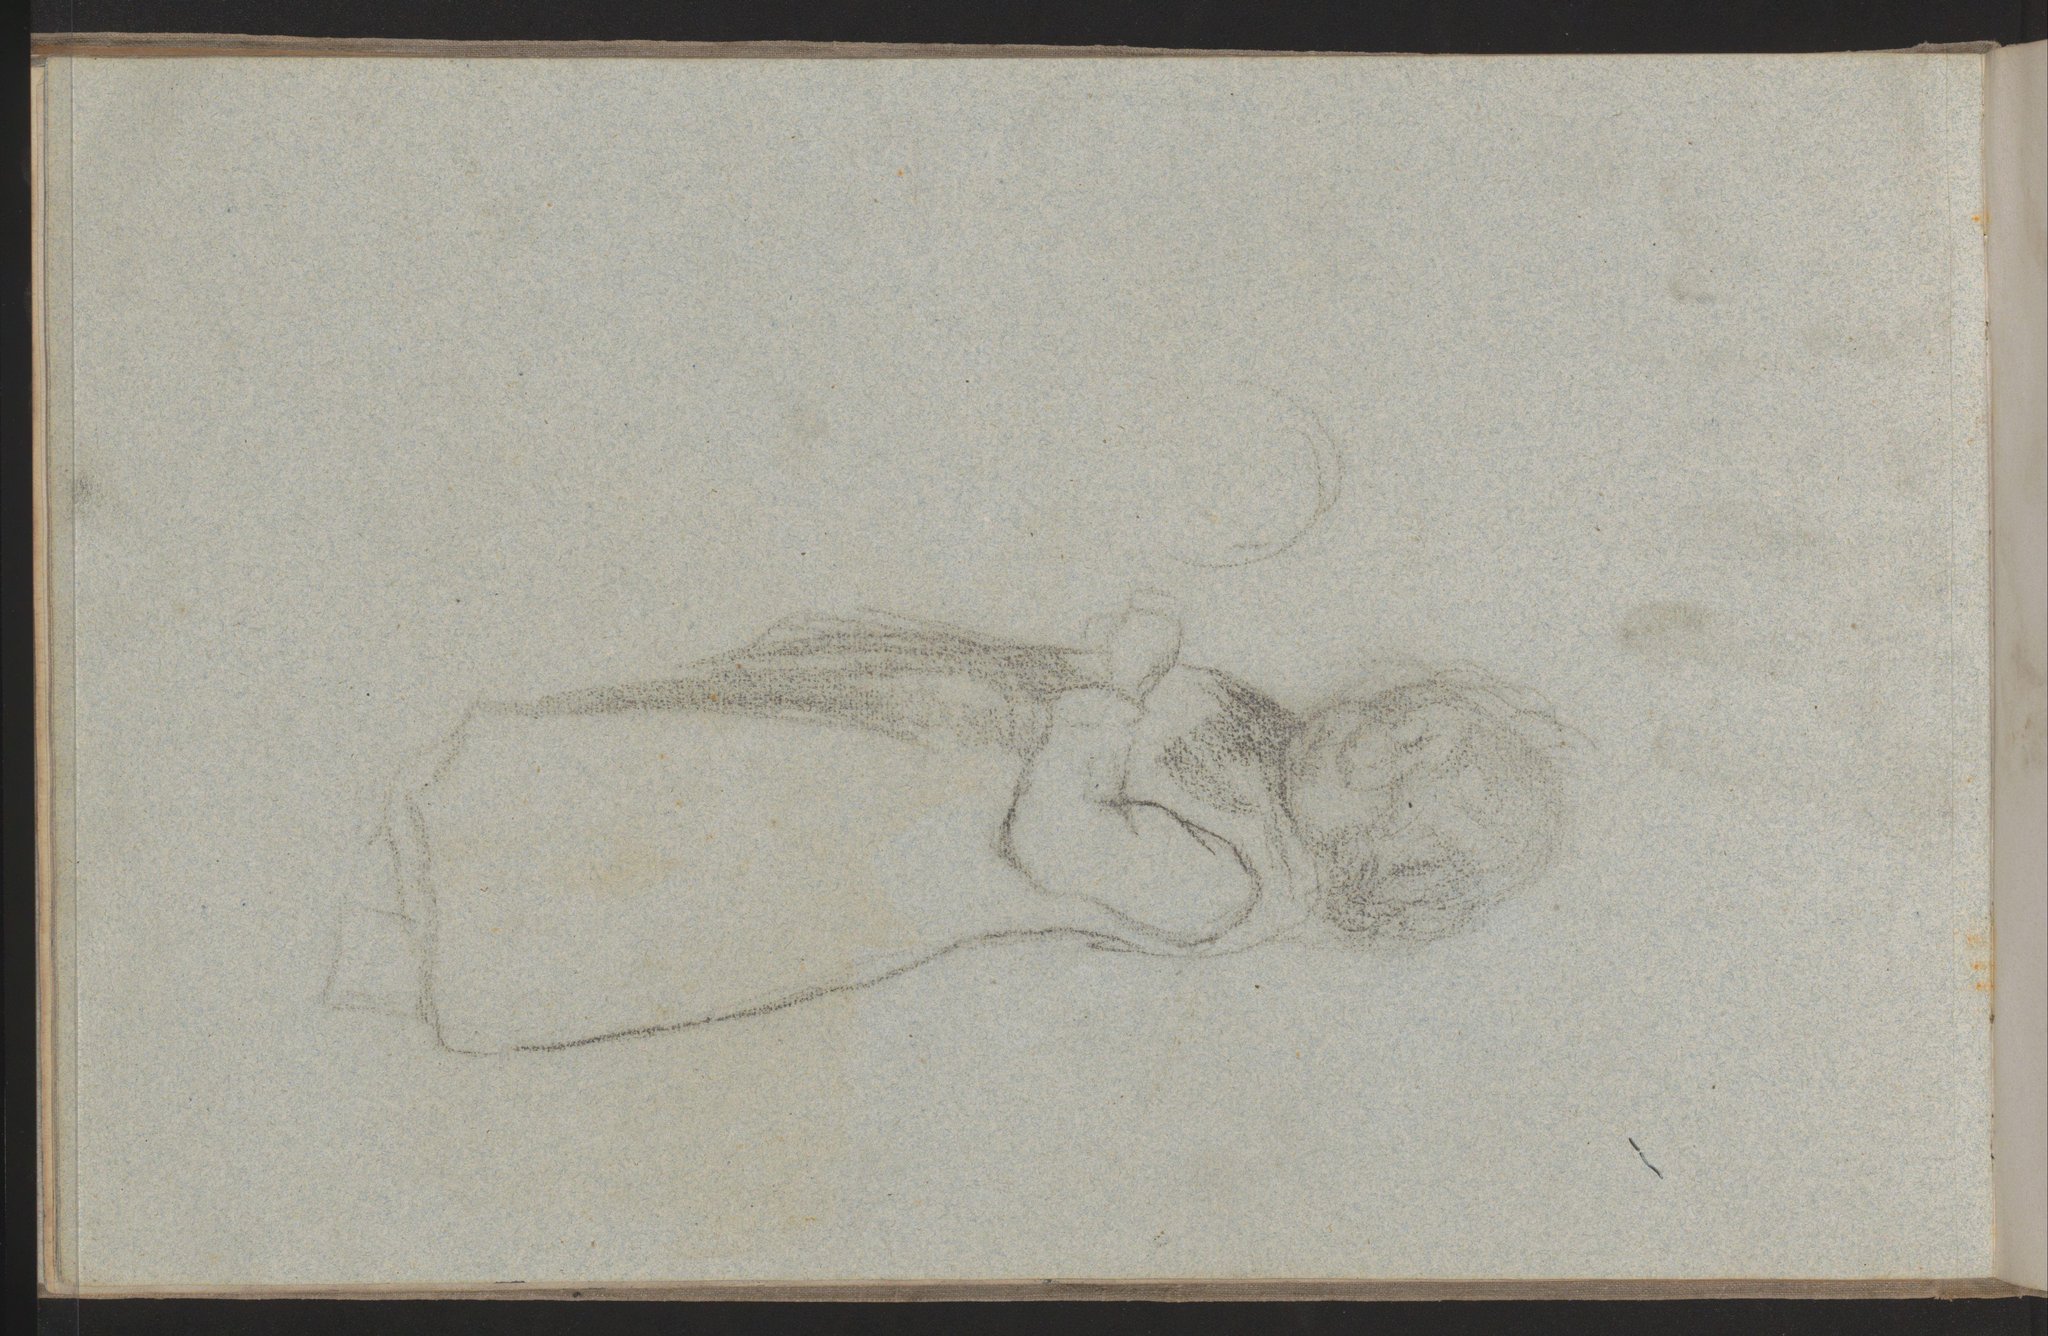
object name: sketchbook leaf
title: Meisje, van opzij gezien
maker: albert neuhuys (1844-1914)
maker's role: draughtsman, painter, print maker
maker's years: 1844-1914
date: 1854-1914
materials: charcoal, paper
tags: girl (child between toddler and youth)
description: Blad 29 verso uit een schetsboek met 51 bladen.